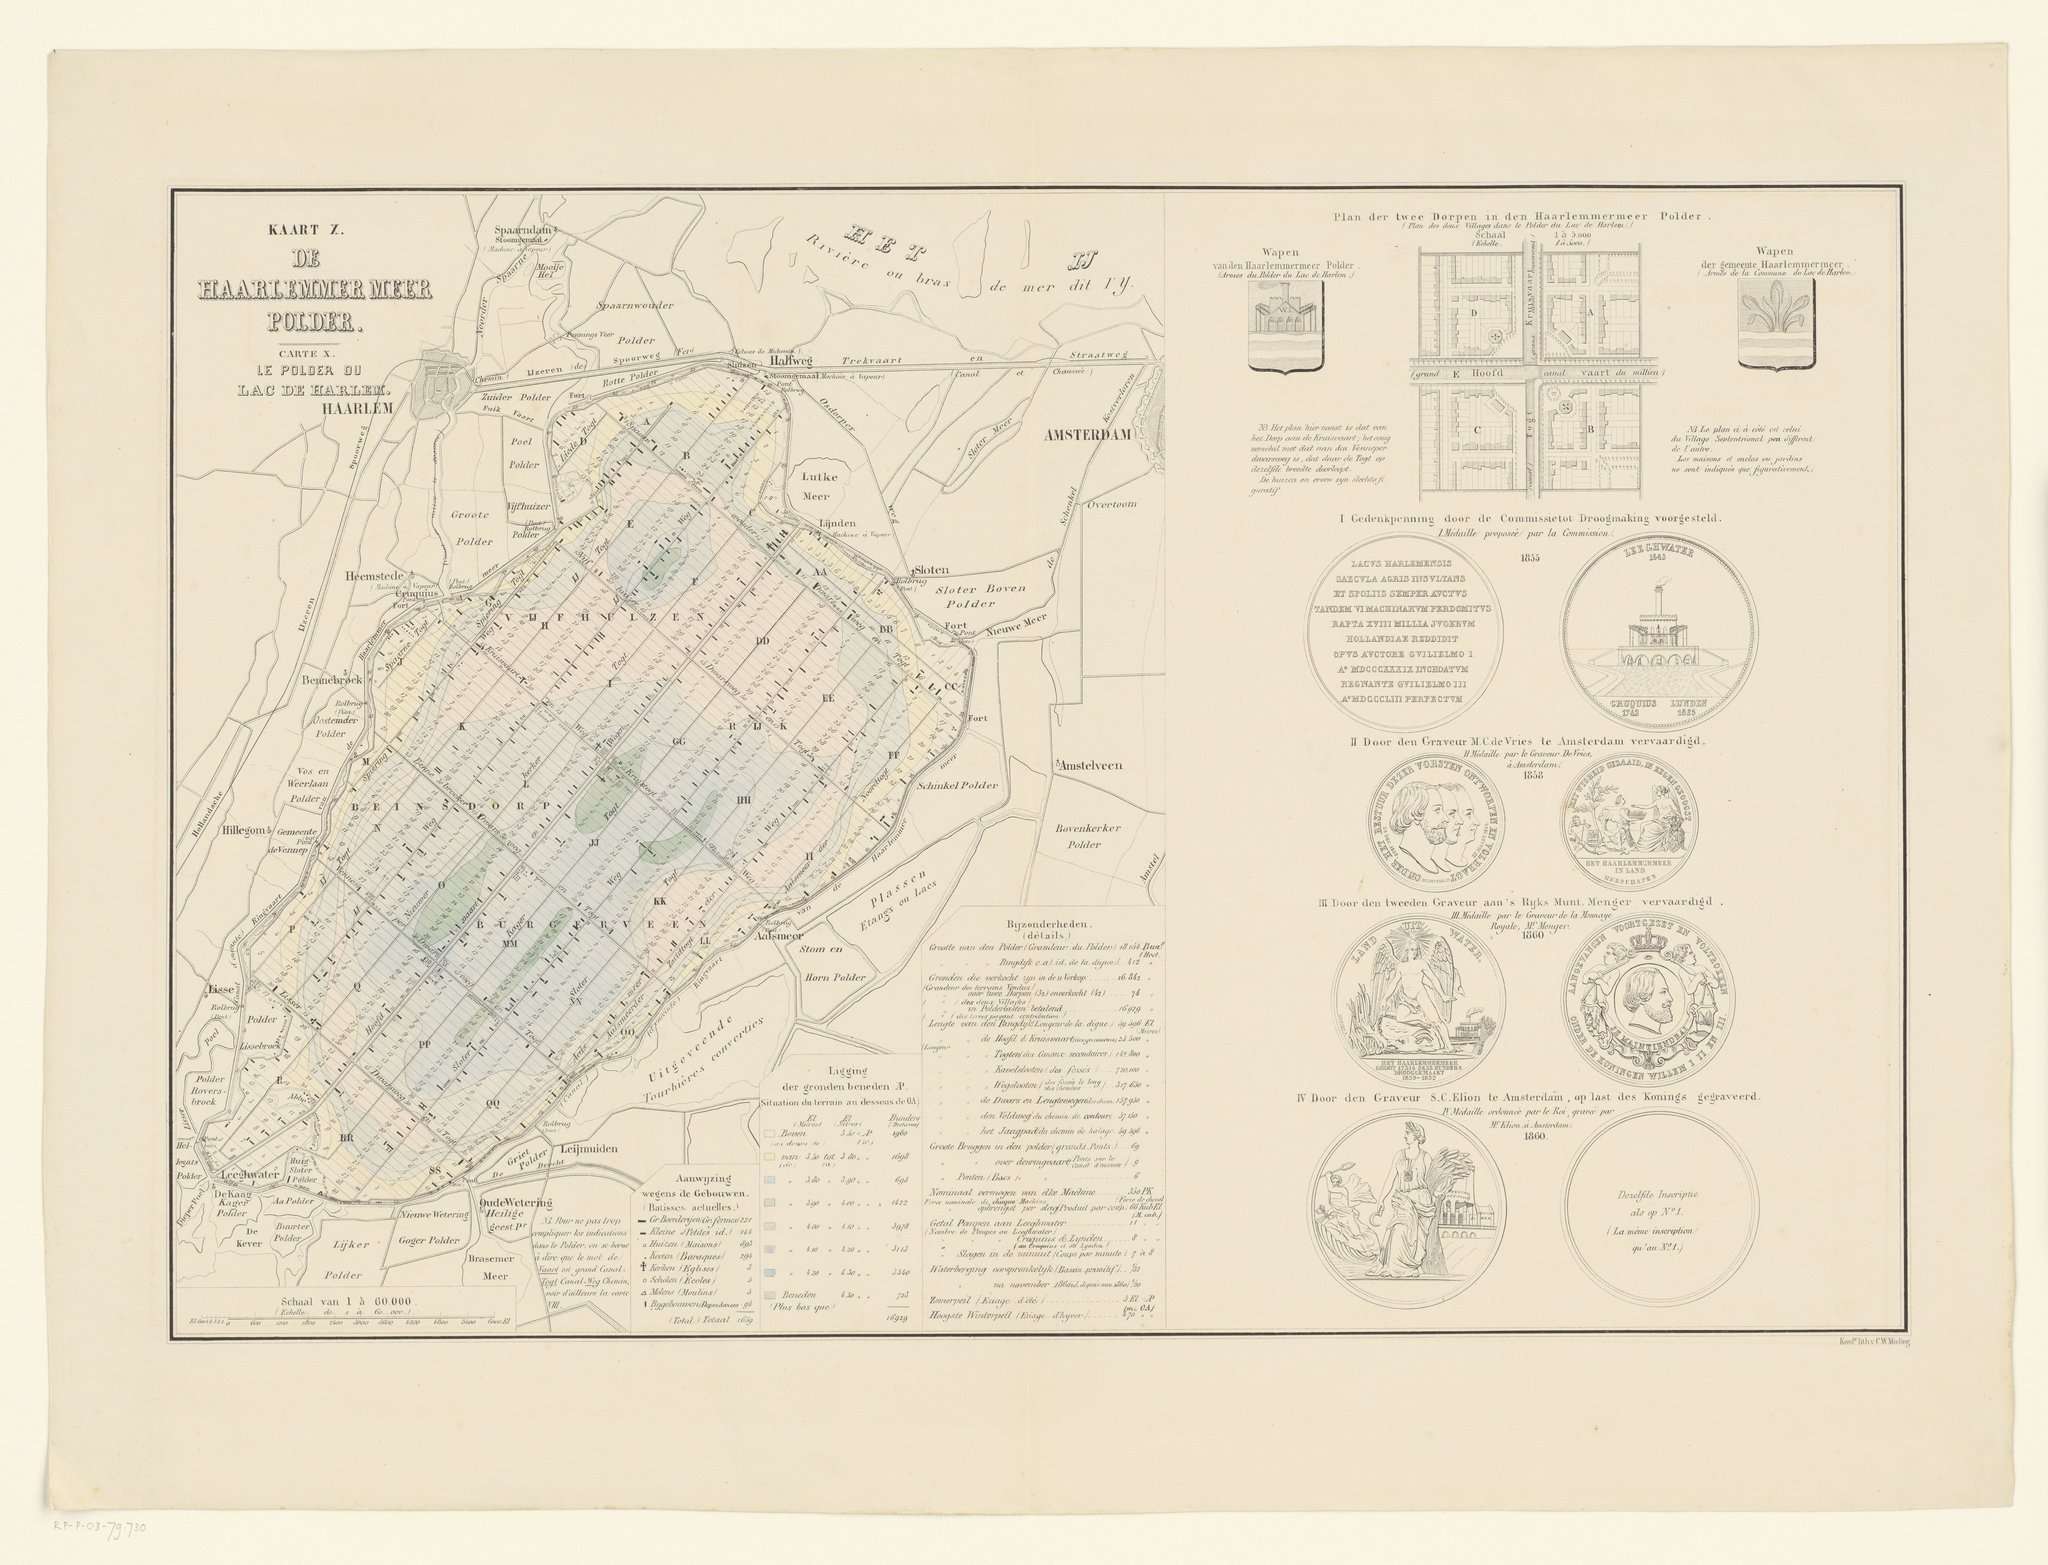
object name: map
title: Suite van tien kaarten en platen van de droogmaking van de Haarlemmermeer 1843-1860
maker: Anonymous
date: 1860-1861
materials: paper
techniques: hand coloring, lithograph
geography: netherlands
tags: maps of separate countries or regions, medal (considered as a piece of sculpture, regardless of its specific function), polder, reclaimed land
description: Kaart van de verkaveling van de Haarlemmermeerpolder. Rechts een plattegrond van twee nieuwe dorpen gepland in de polder. Daar onder vier penningen (uit 1855, 1858, en twee uit 1860) ter viering van de droogmaking. Opschriften in het Nederlands en Frans. Onderdeel van een suite van tien platen van de droogmaking van de Haarlemmermeer, 1843-1860.